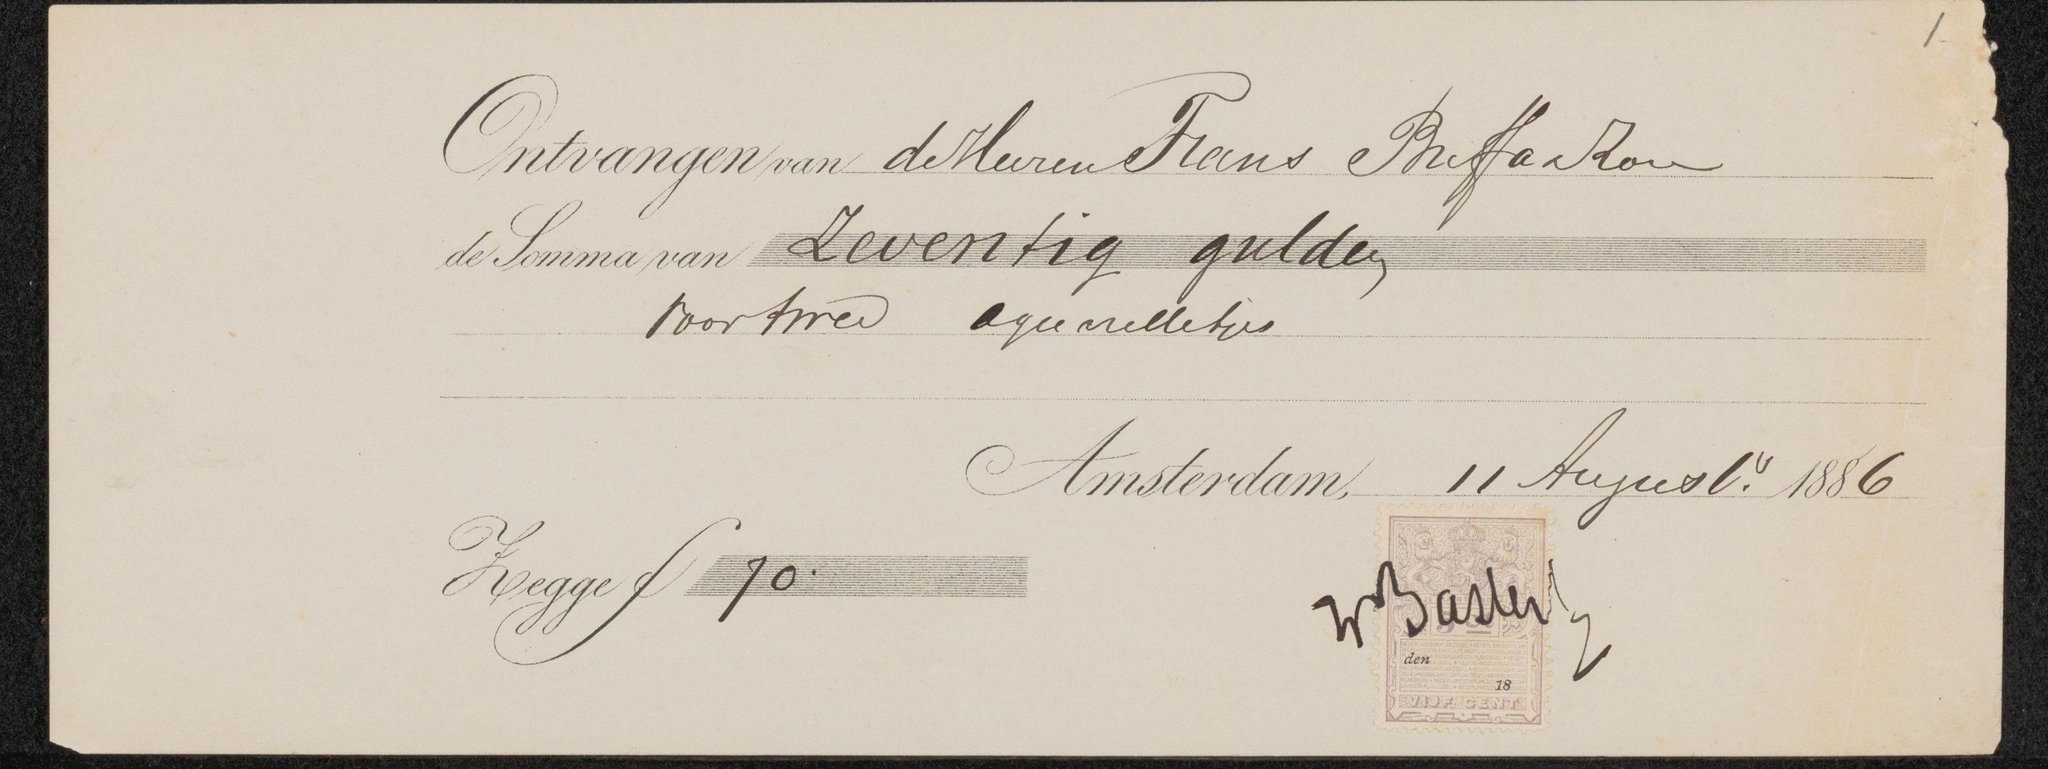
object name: ontvangstbewijs, kwitantie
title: Kwitantie voor Nicolaas Bastert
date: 1886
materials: ink, paper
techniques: pen, printing, writing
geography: amsterdam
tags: drawing, money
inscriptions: collector's mark: Lugt 2233